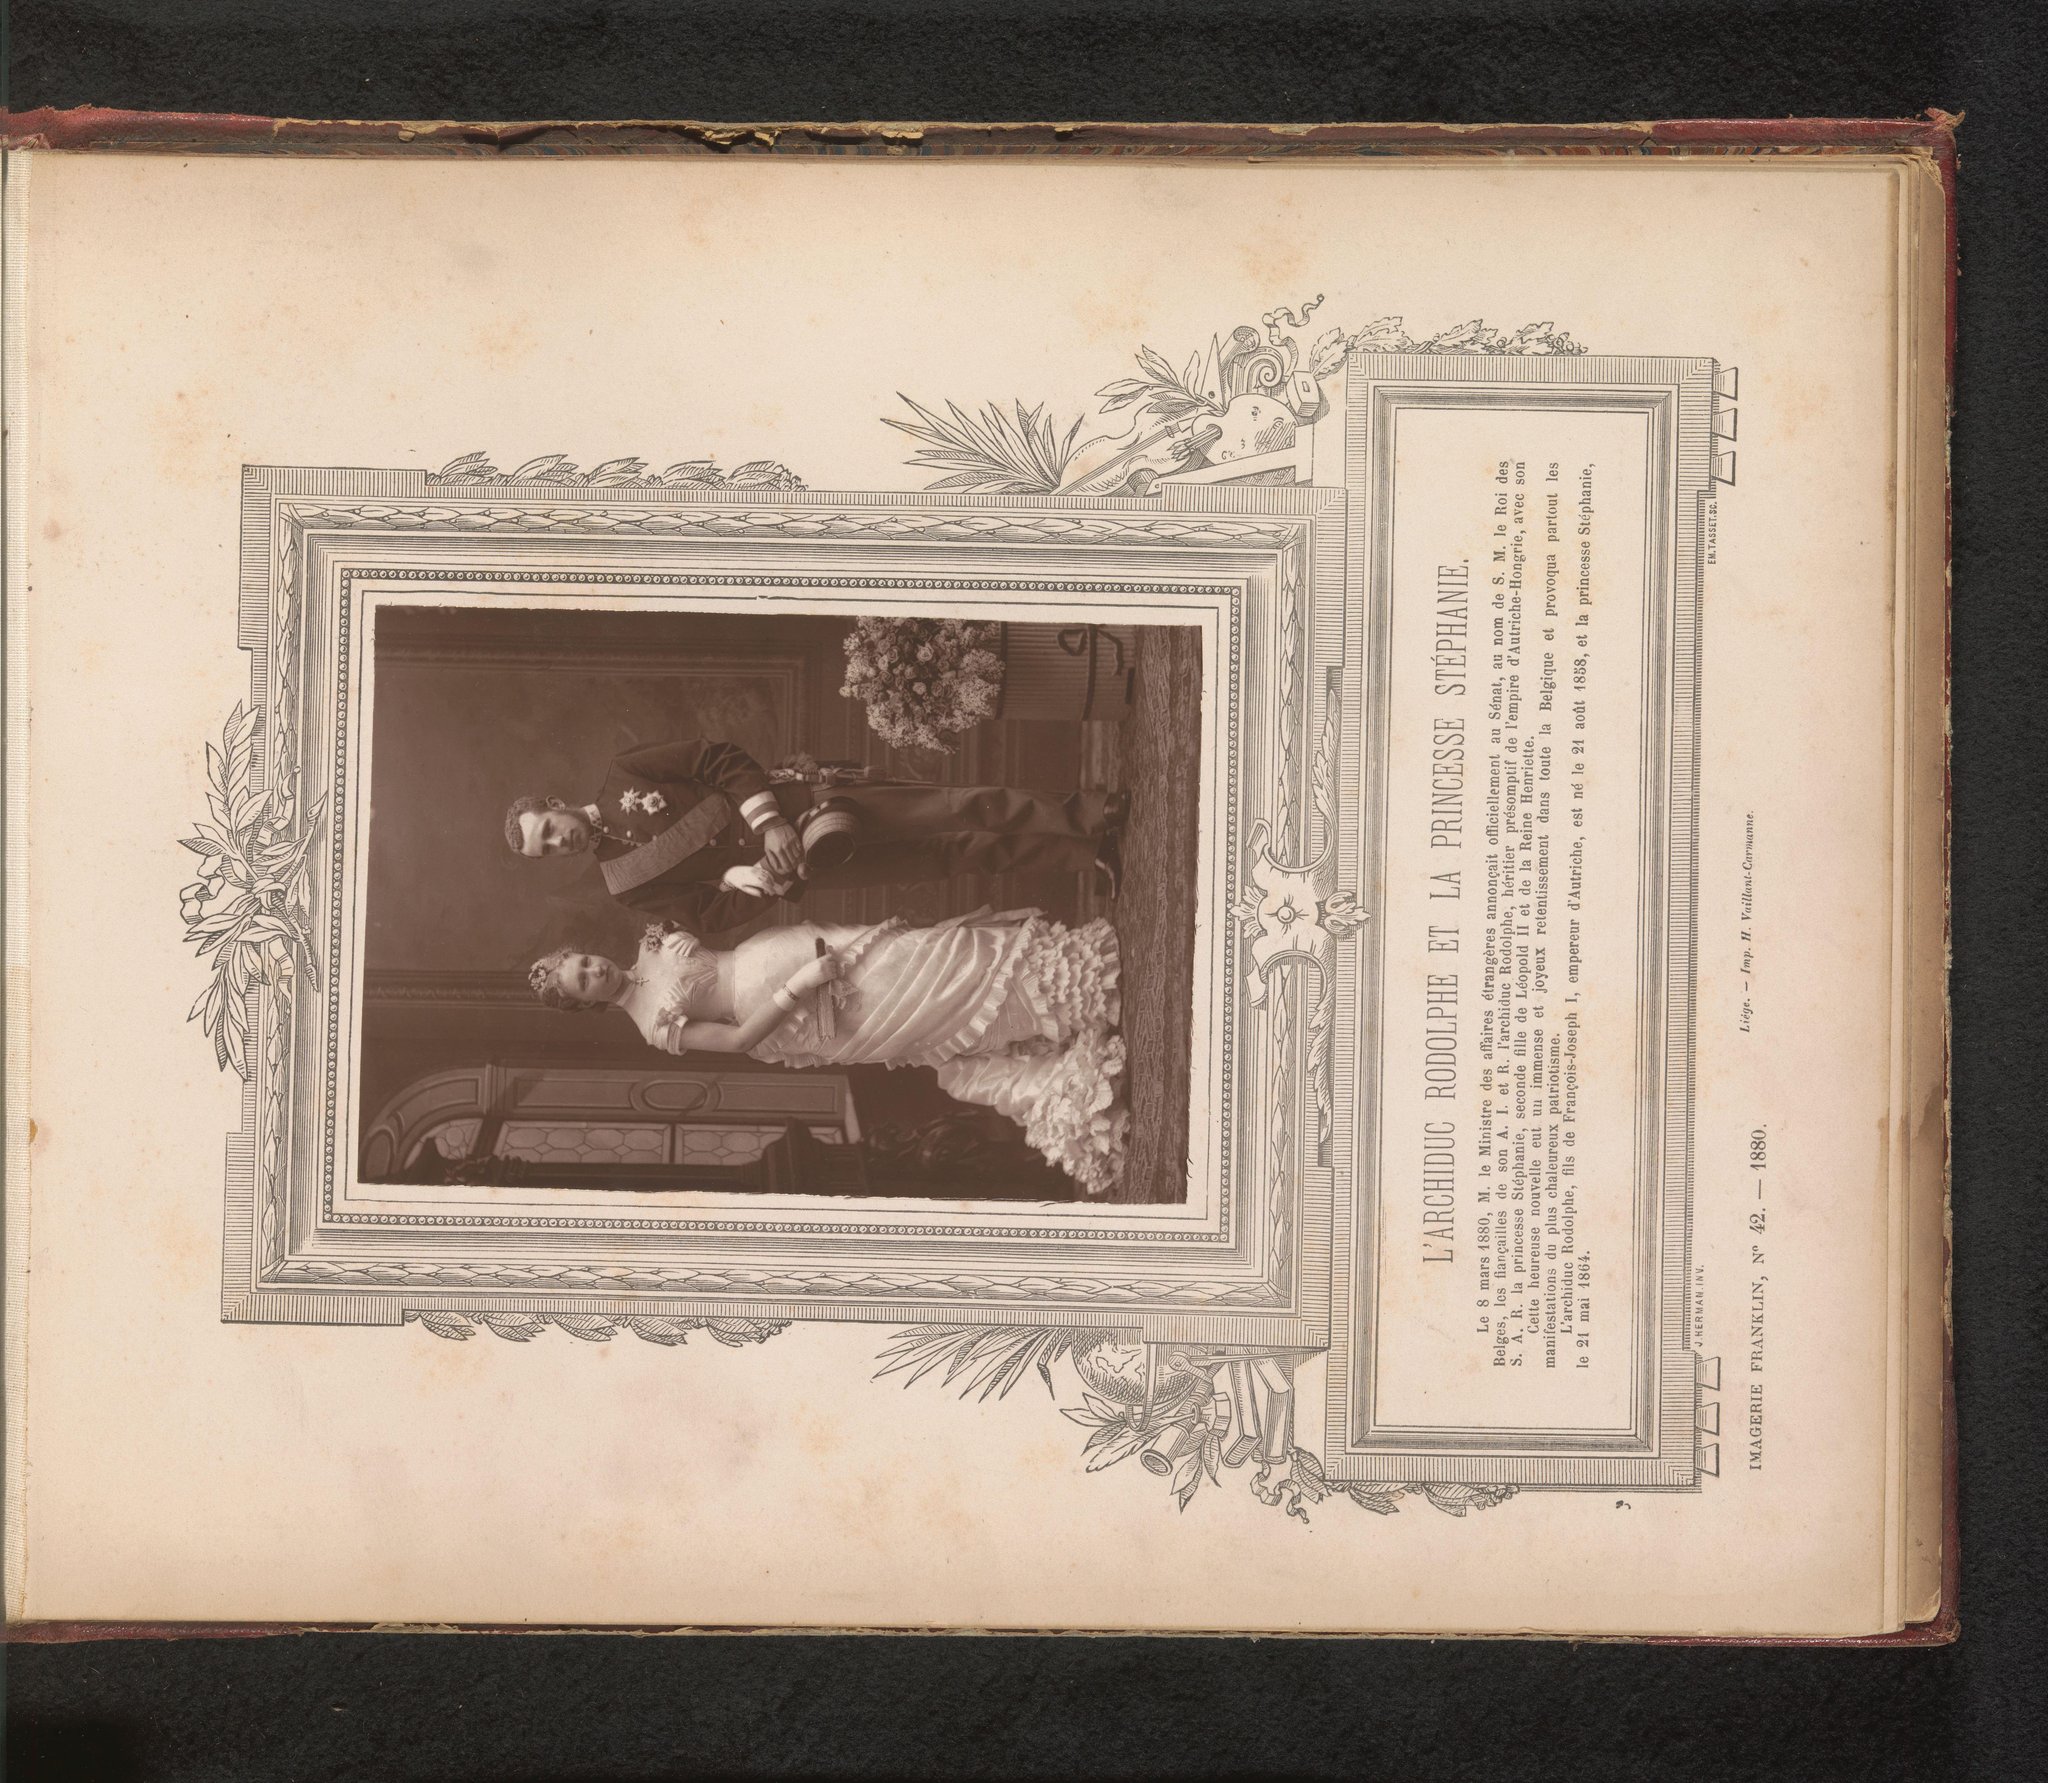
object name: photomechanical print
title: Portret van Rudolf van Oostenrijk en Stefanie van België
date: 1875-1880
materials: paper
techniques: woodburytype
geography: liège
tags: brussels, historical persons - bb - woman, historical persons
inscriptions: name: ‘J. HERMAN, INV.’, inscription: ‘Le 8 mars (...) 21 mai 1864.’, name: ‘EM. TASSET, SC.’, inscription: ‘IMAGERIE FRANKLIN, No 42. - 1880’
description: Deze prent maakt deel uit van een album.